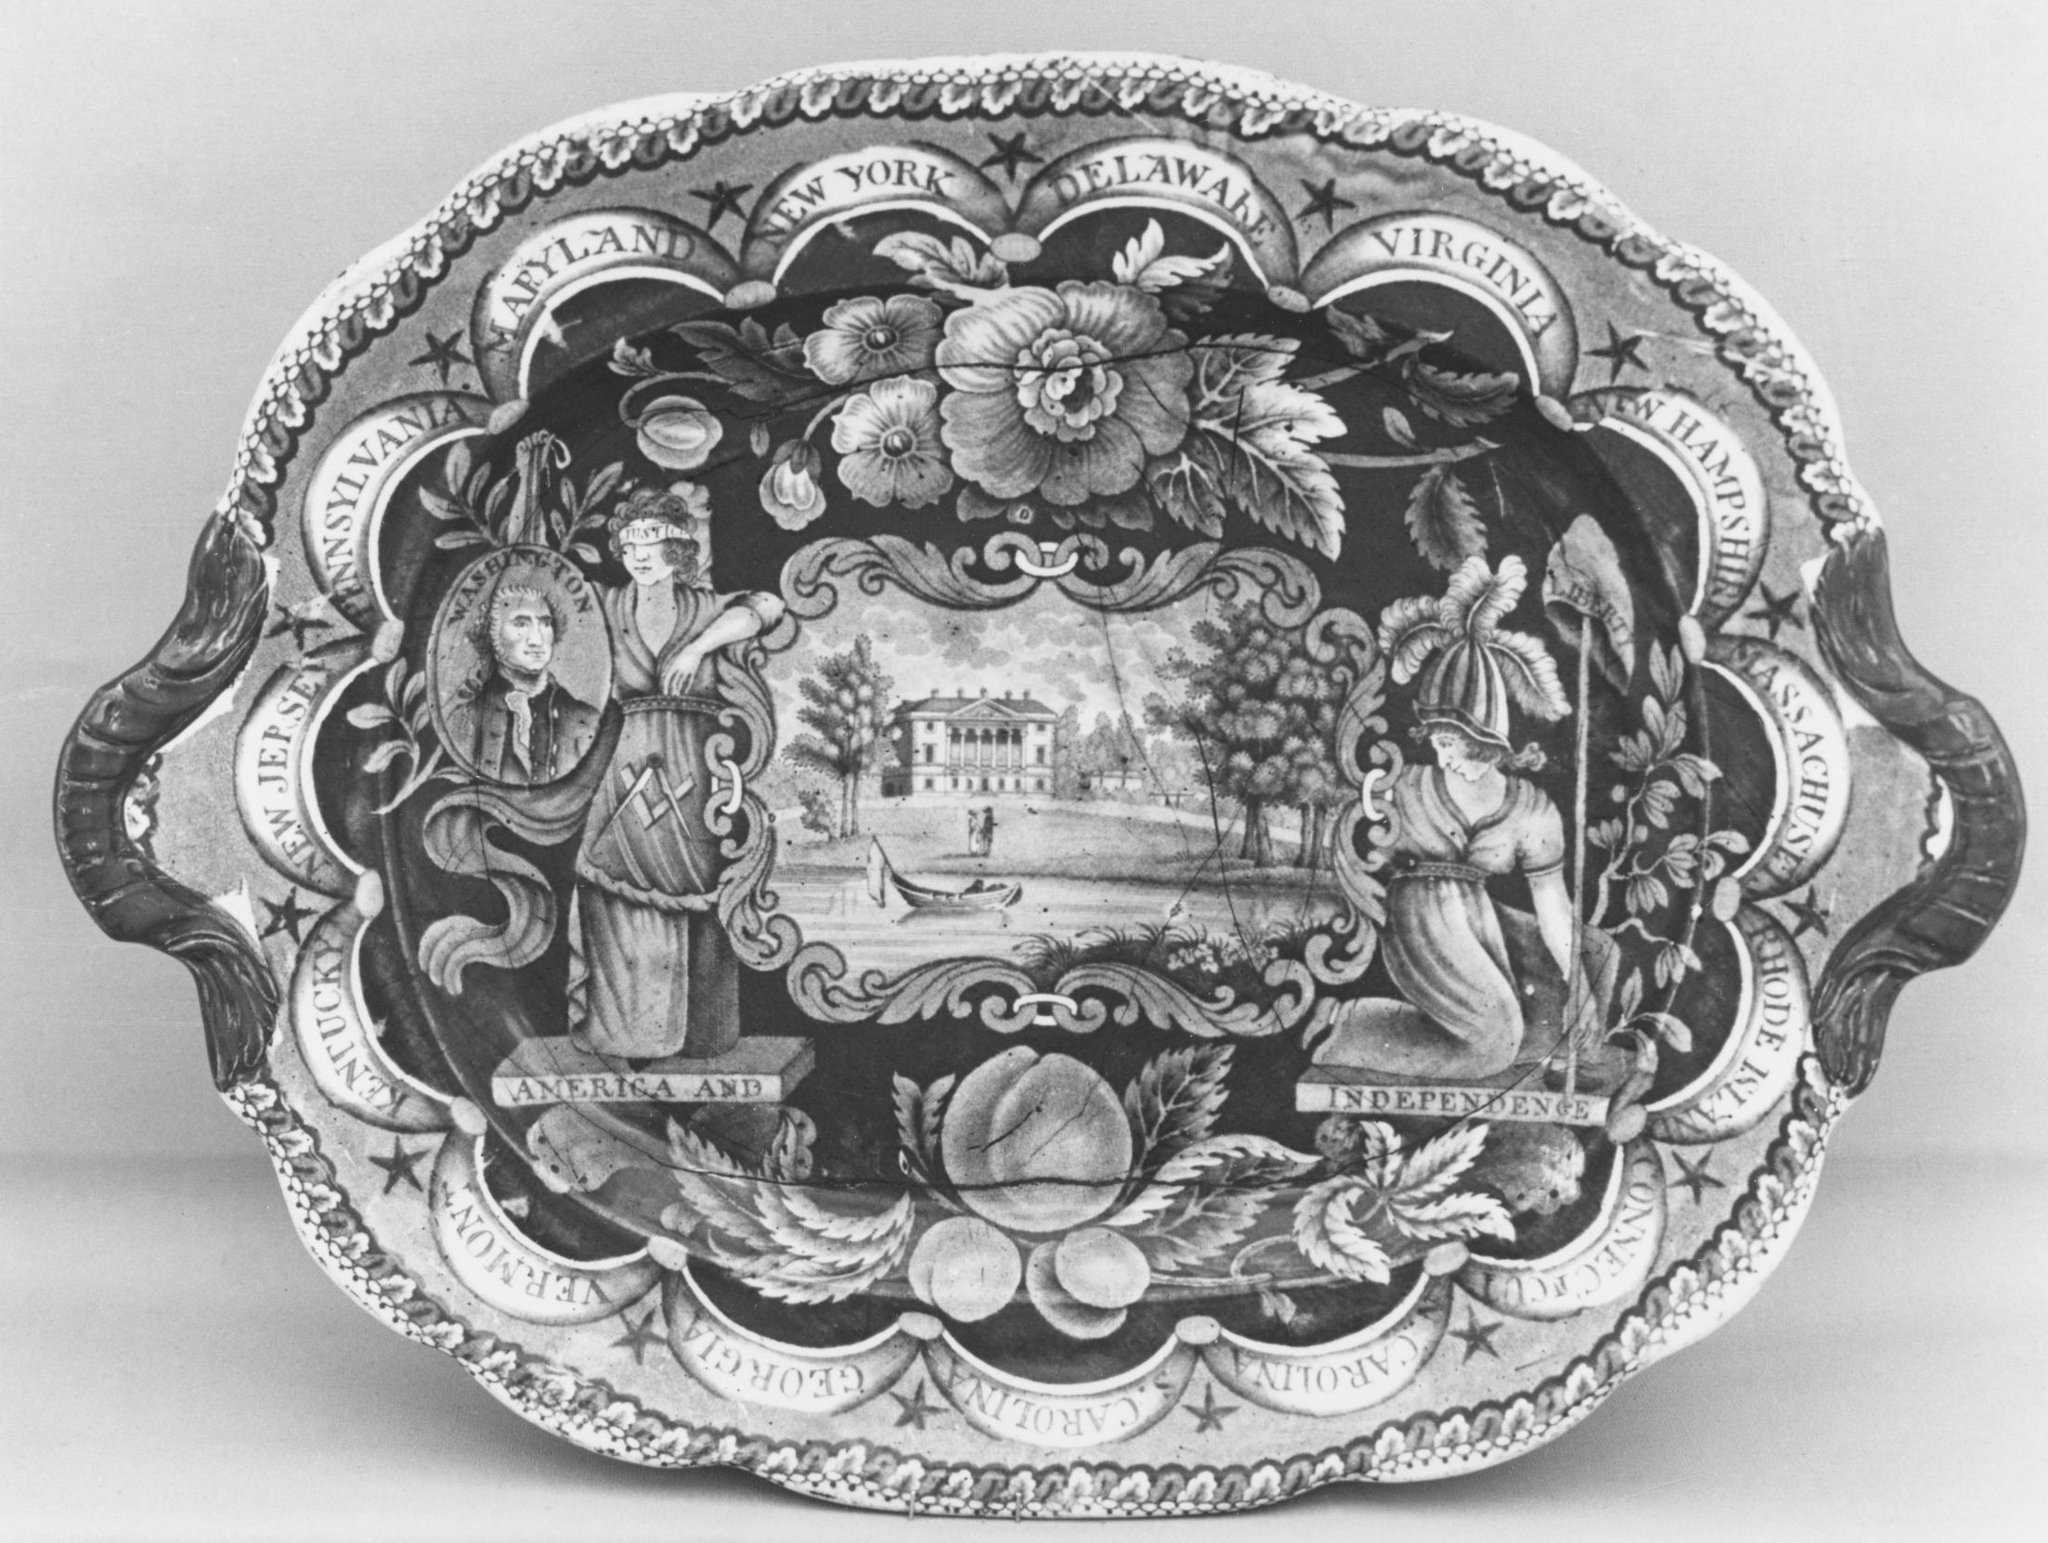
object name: platter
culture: british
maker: james and ralph clews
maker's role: maker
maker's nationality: british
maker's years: 1813-1836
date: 1815-1834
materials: earthenware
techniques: transfer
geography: england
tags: george washington,flowers